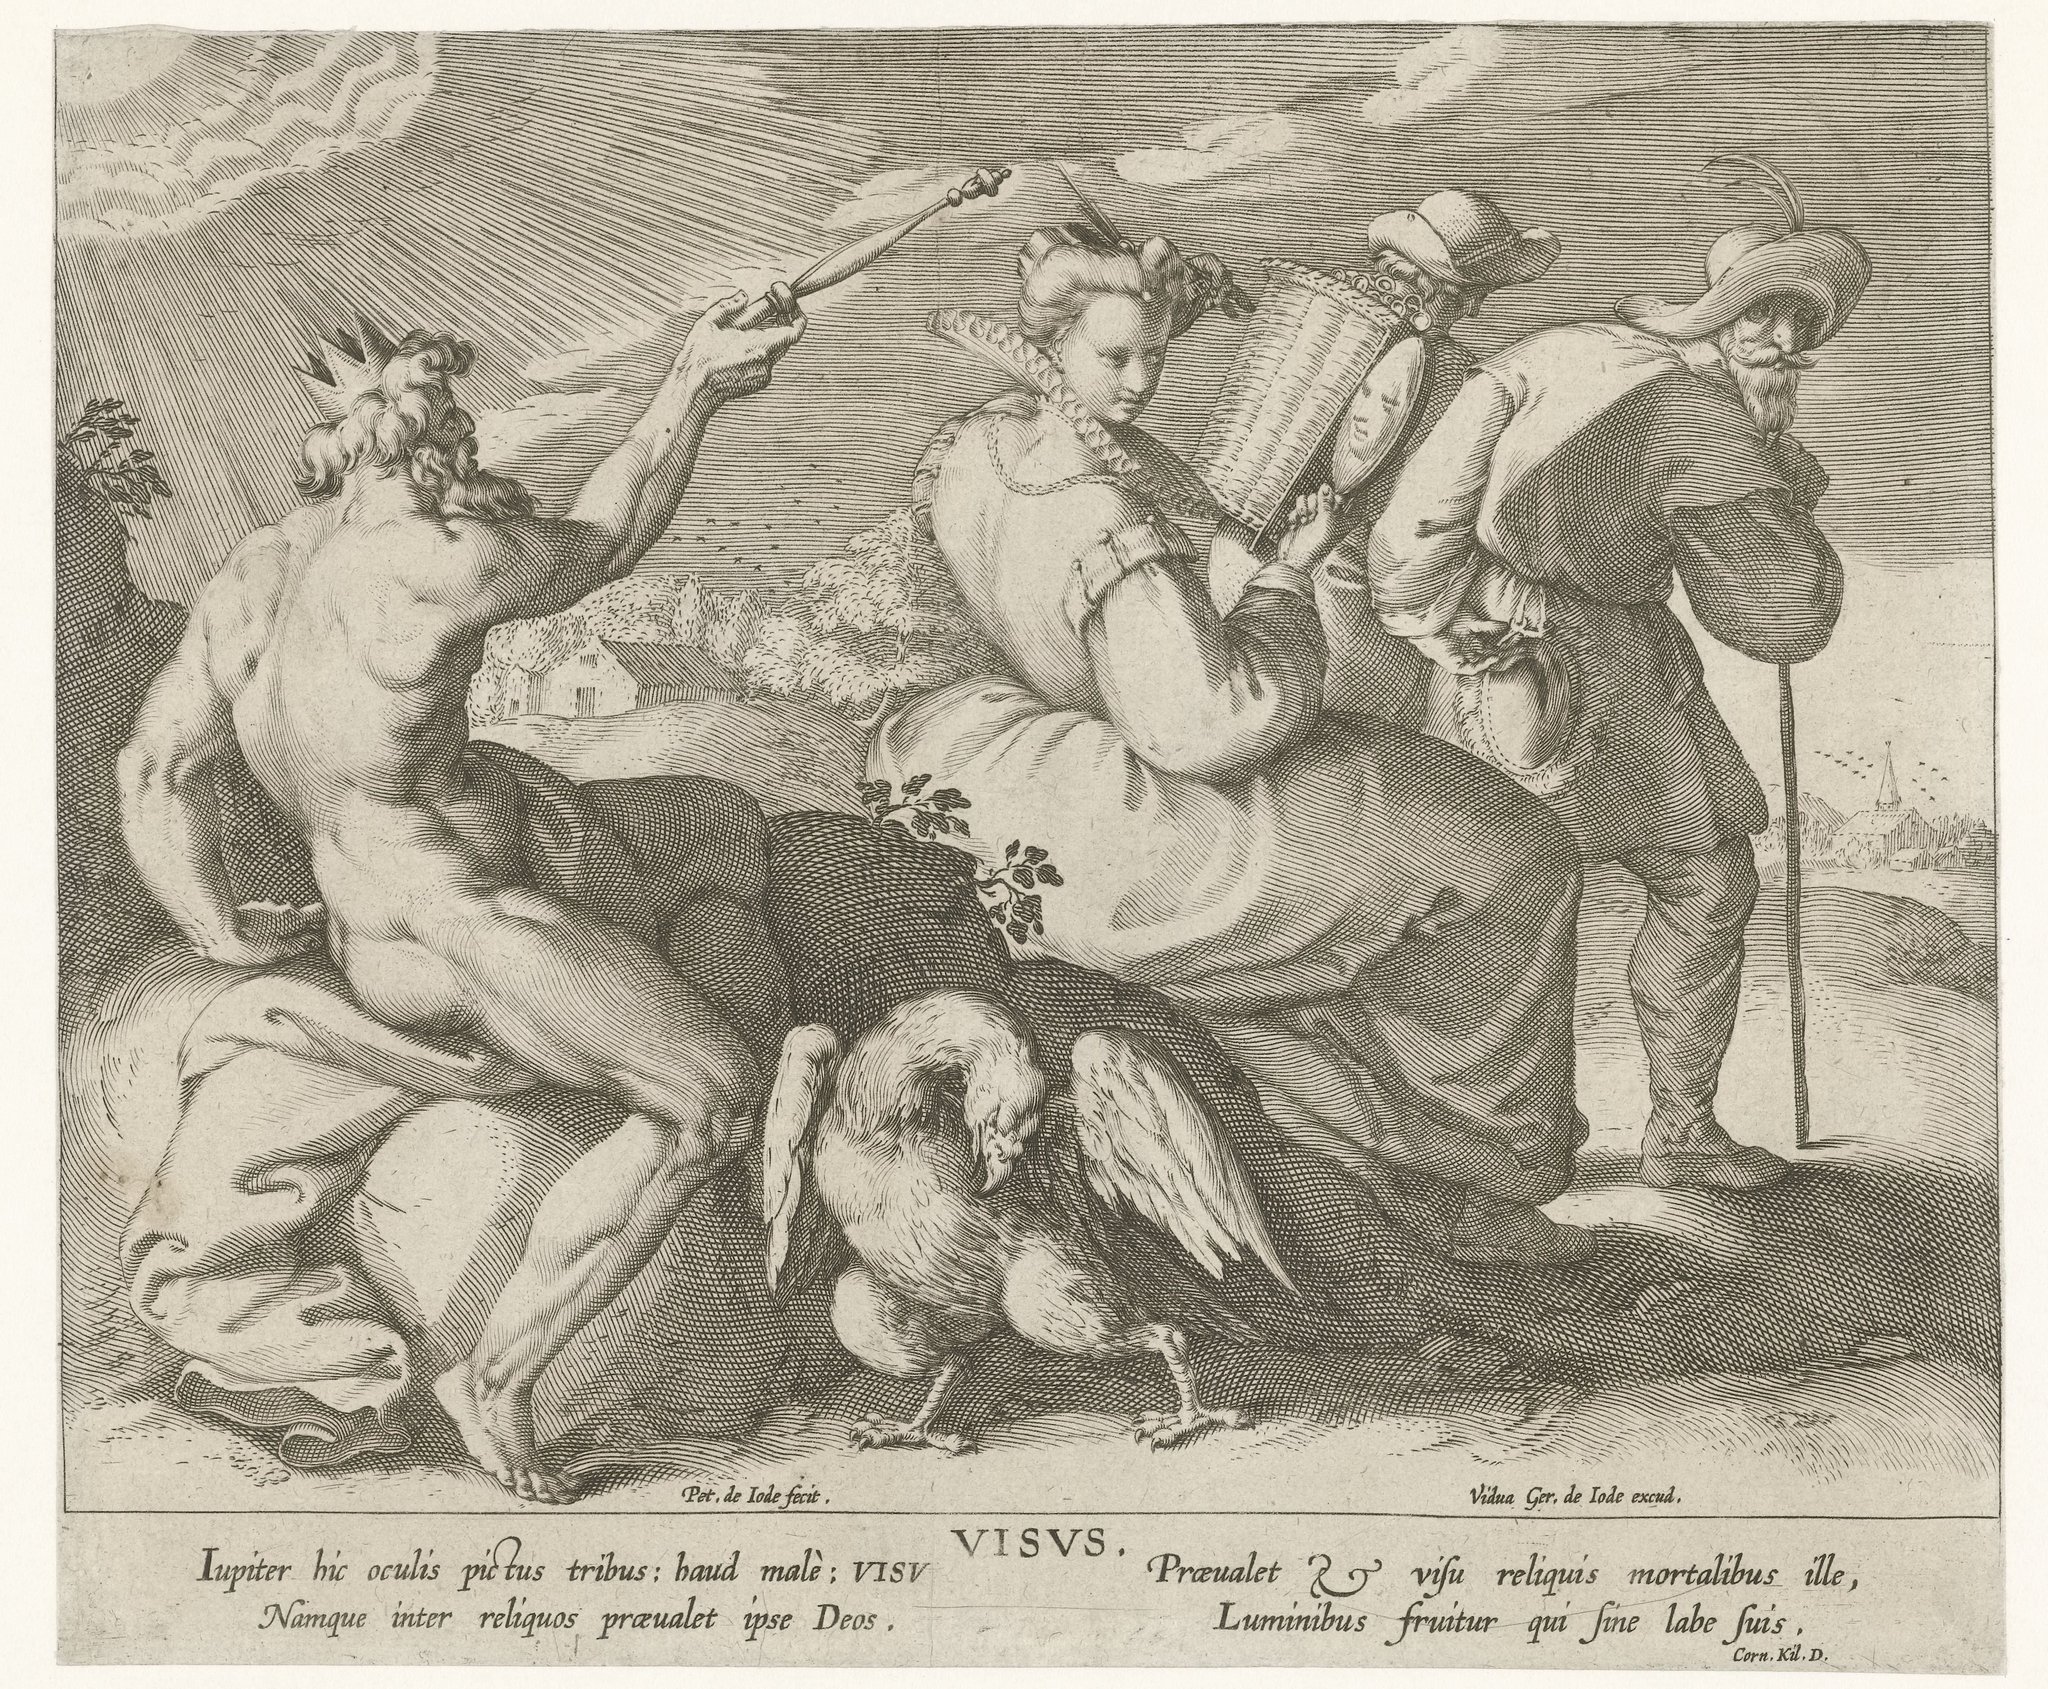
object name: print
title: Gezicht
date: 1590-1632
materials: paper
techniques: engraving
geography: antwerp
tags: sight, looking (one of the five senses), (story of) jupiter (zeus)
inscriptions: collector's mark: Lugt 2760, collector's mark: Lugt 2228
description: Landschap met de vrouwelijke personificatie van het Gezicht. Ze heeft een spiegel vast en kijkt daarin. Voor haar staan twee mannen, van wie de rechter een spiegel achter zijn rug houdt. Achter haar zit Jupiter, vergezeld door de adelaar, met een scepter in zijn rechterhand. In de marge, in twee kolommen, een onderschrift in het Latijn. Prent uit een serie van vijf met de vijf zintuigen.